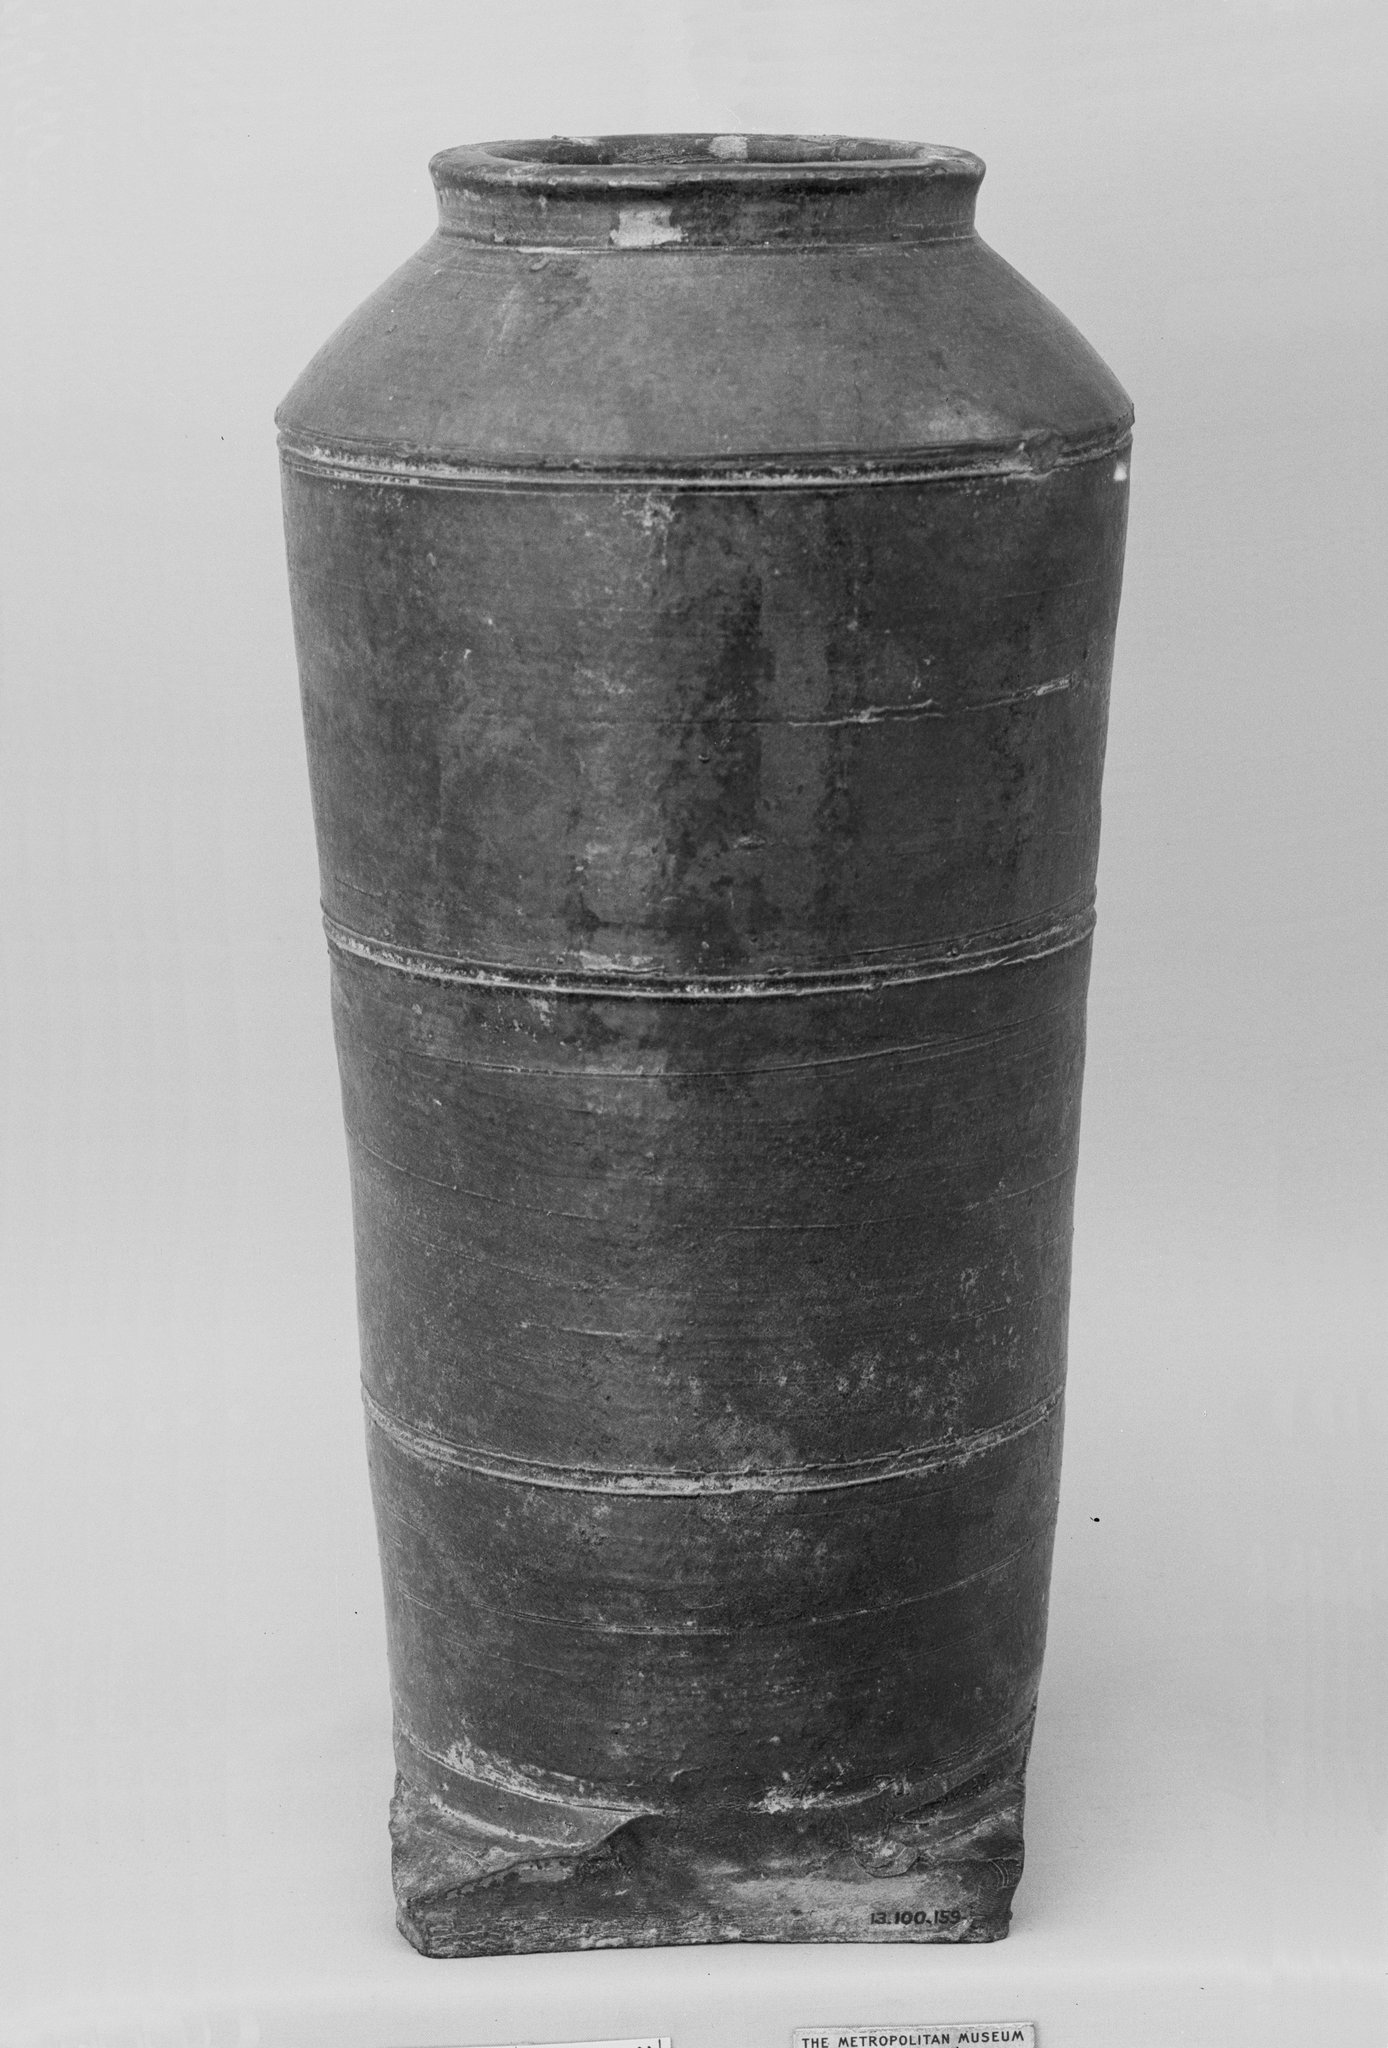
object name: mortuary urn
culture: chinese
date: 206 BCE-220 CE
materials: earthenware